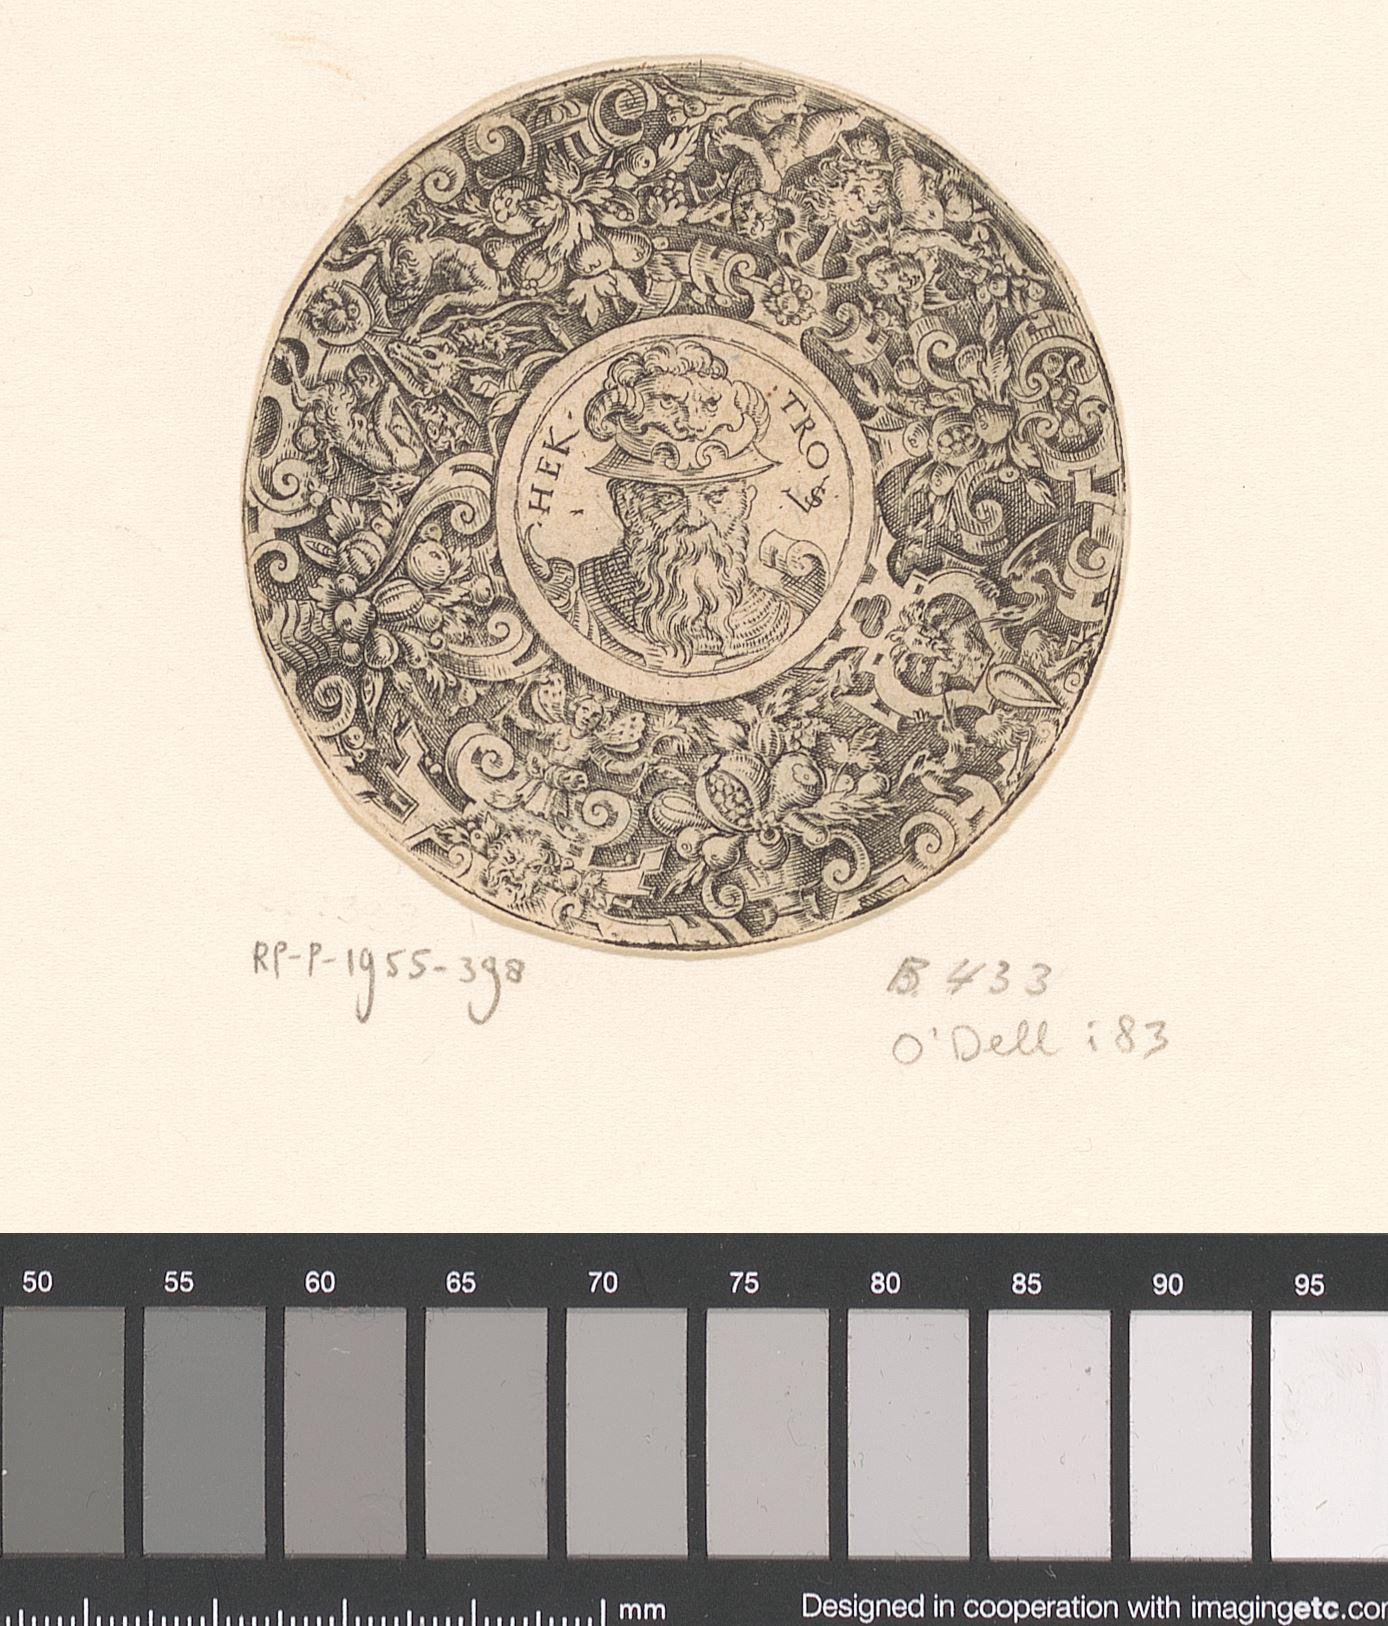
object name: ornament print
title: Rond ontwerp met ornamenten en een buste van Hector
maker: virgilius solis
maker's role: draughtsman, print maker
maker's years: 1514-1562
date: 1524-1562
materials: paper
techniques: engraving, etching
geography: nuremberg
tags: fruits and vegetables ~ ornament, satyr(s) (in general), mask, mascaron ~ ornament, hector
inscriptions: collector's mark: Lugt 2228